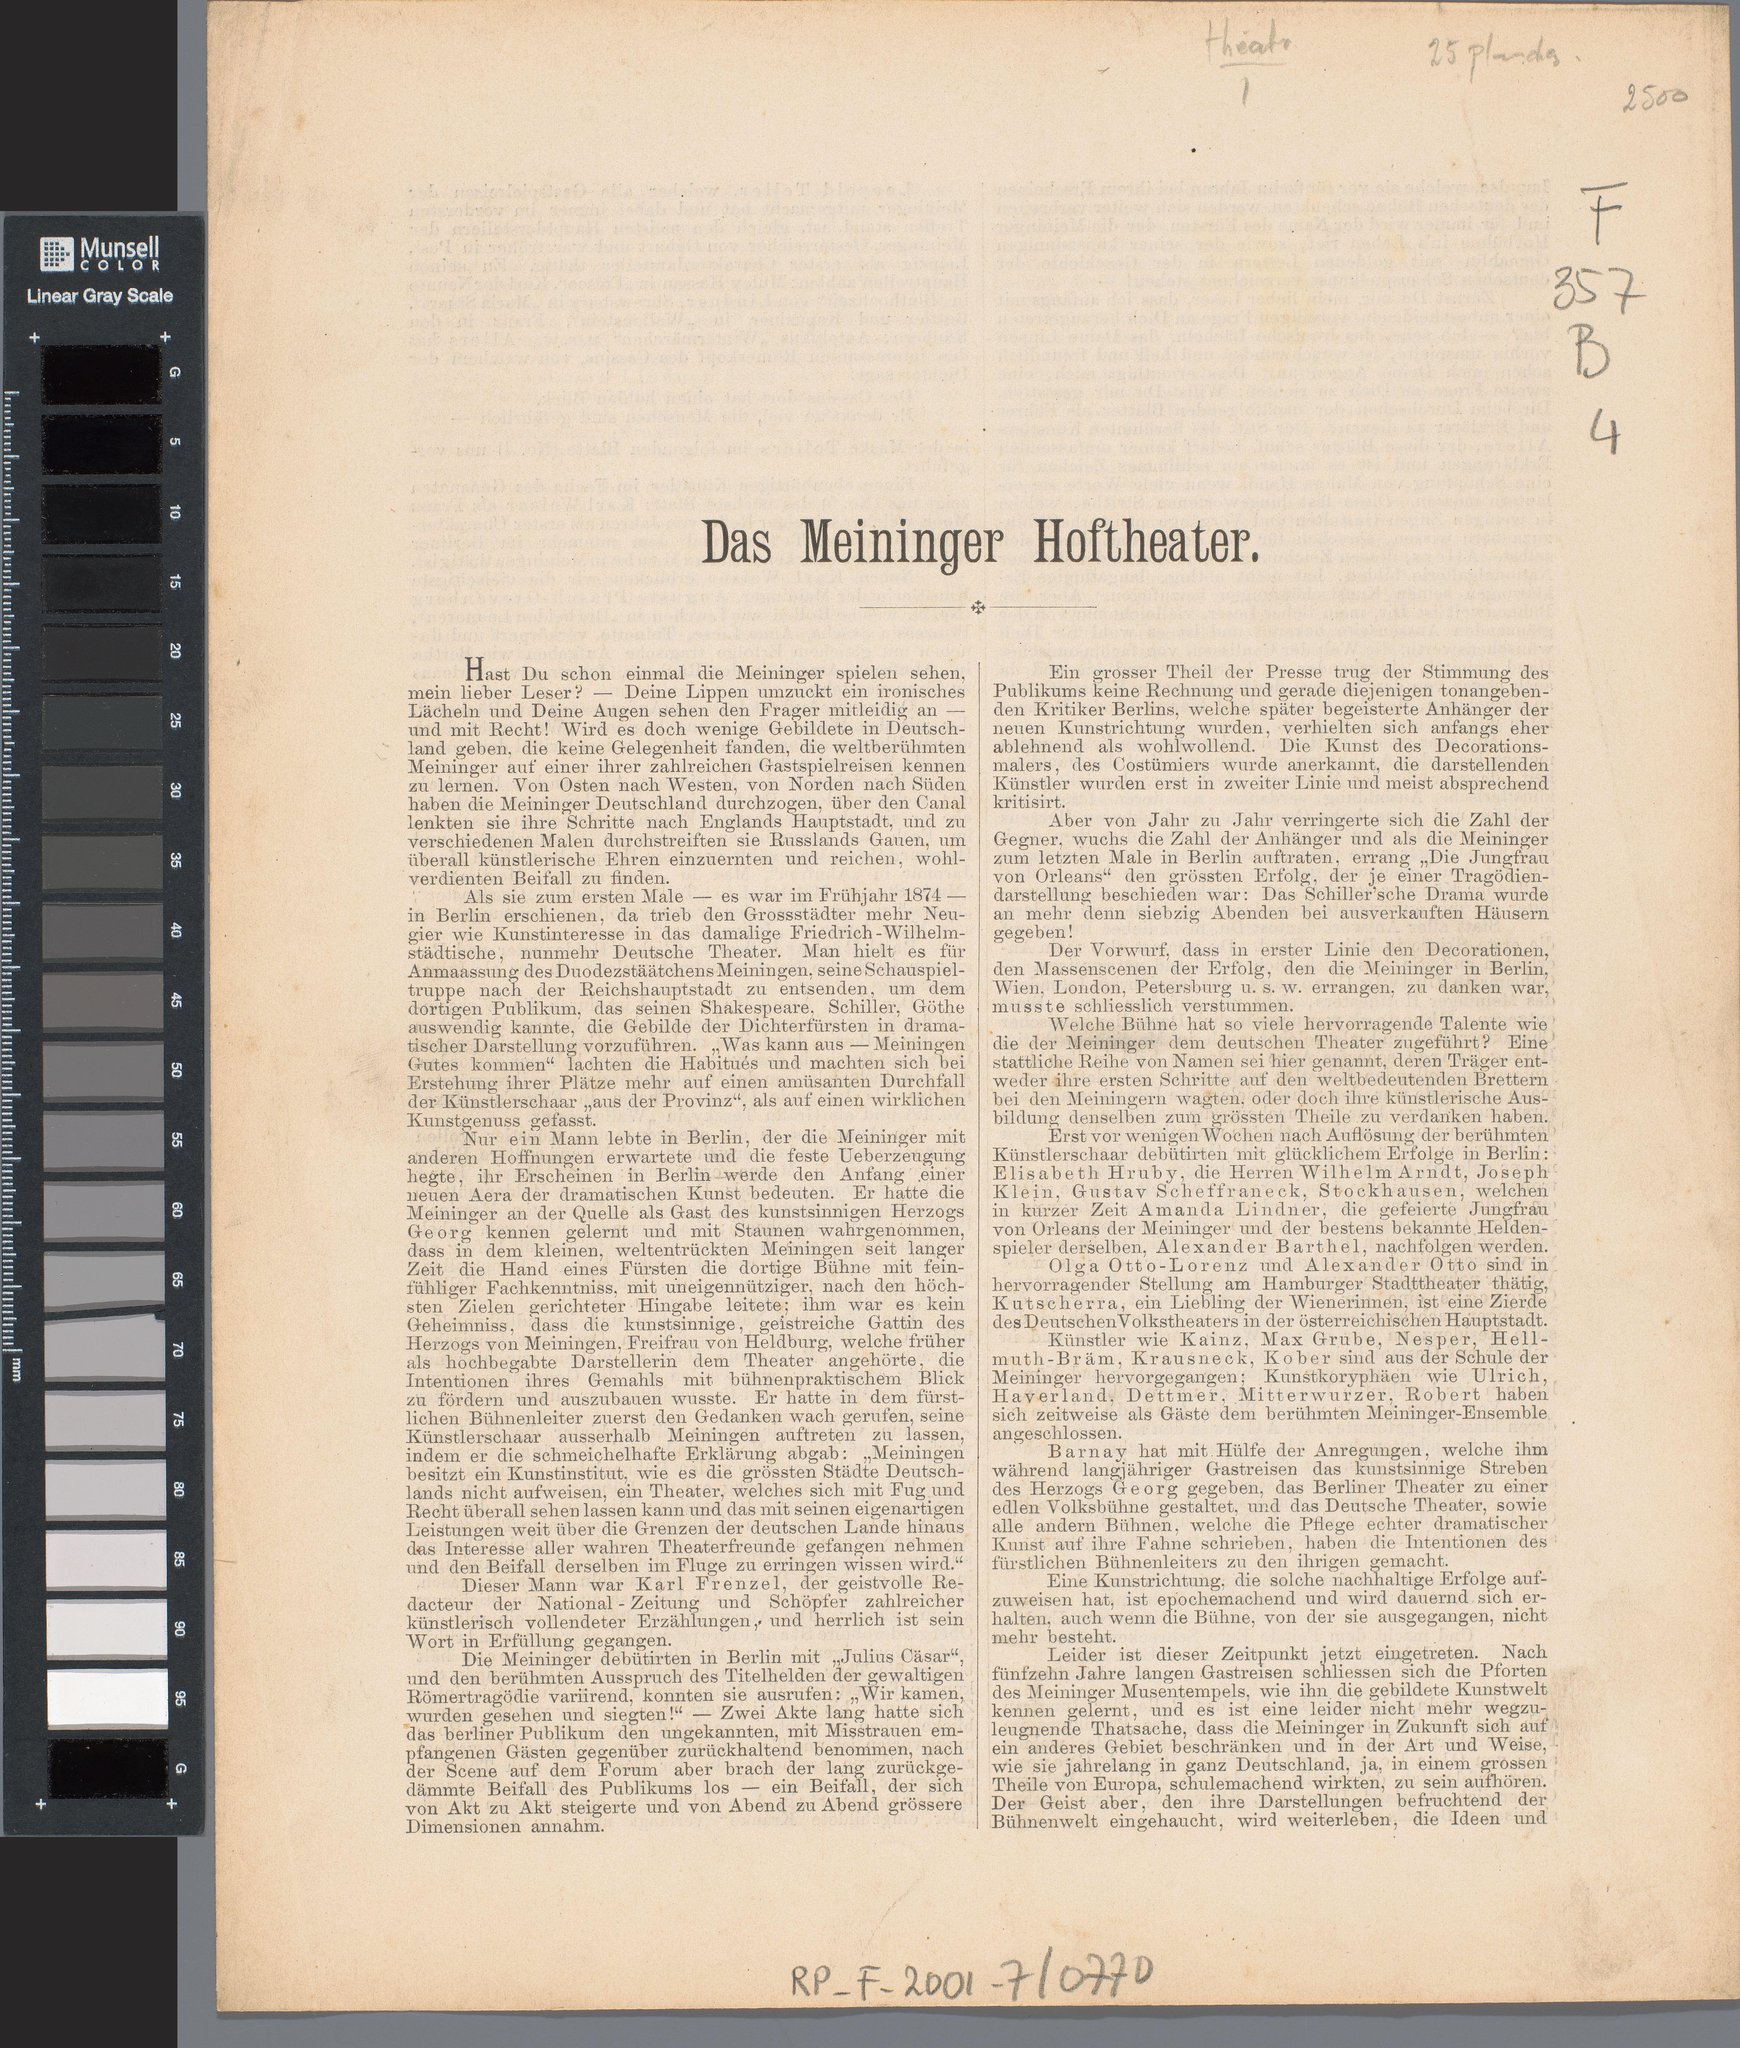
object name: page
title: Die Meininger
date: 1890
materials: cardboard, linen, paper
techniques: photograph, printing